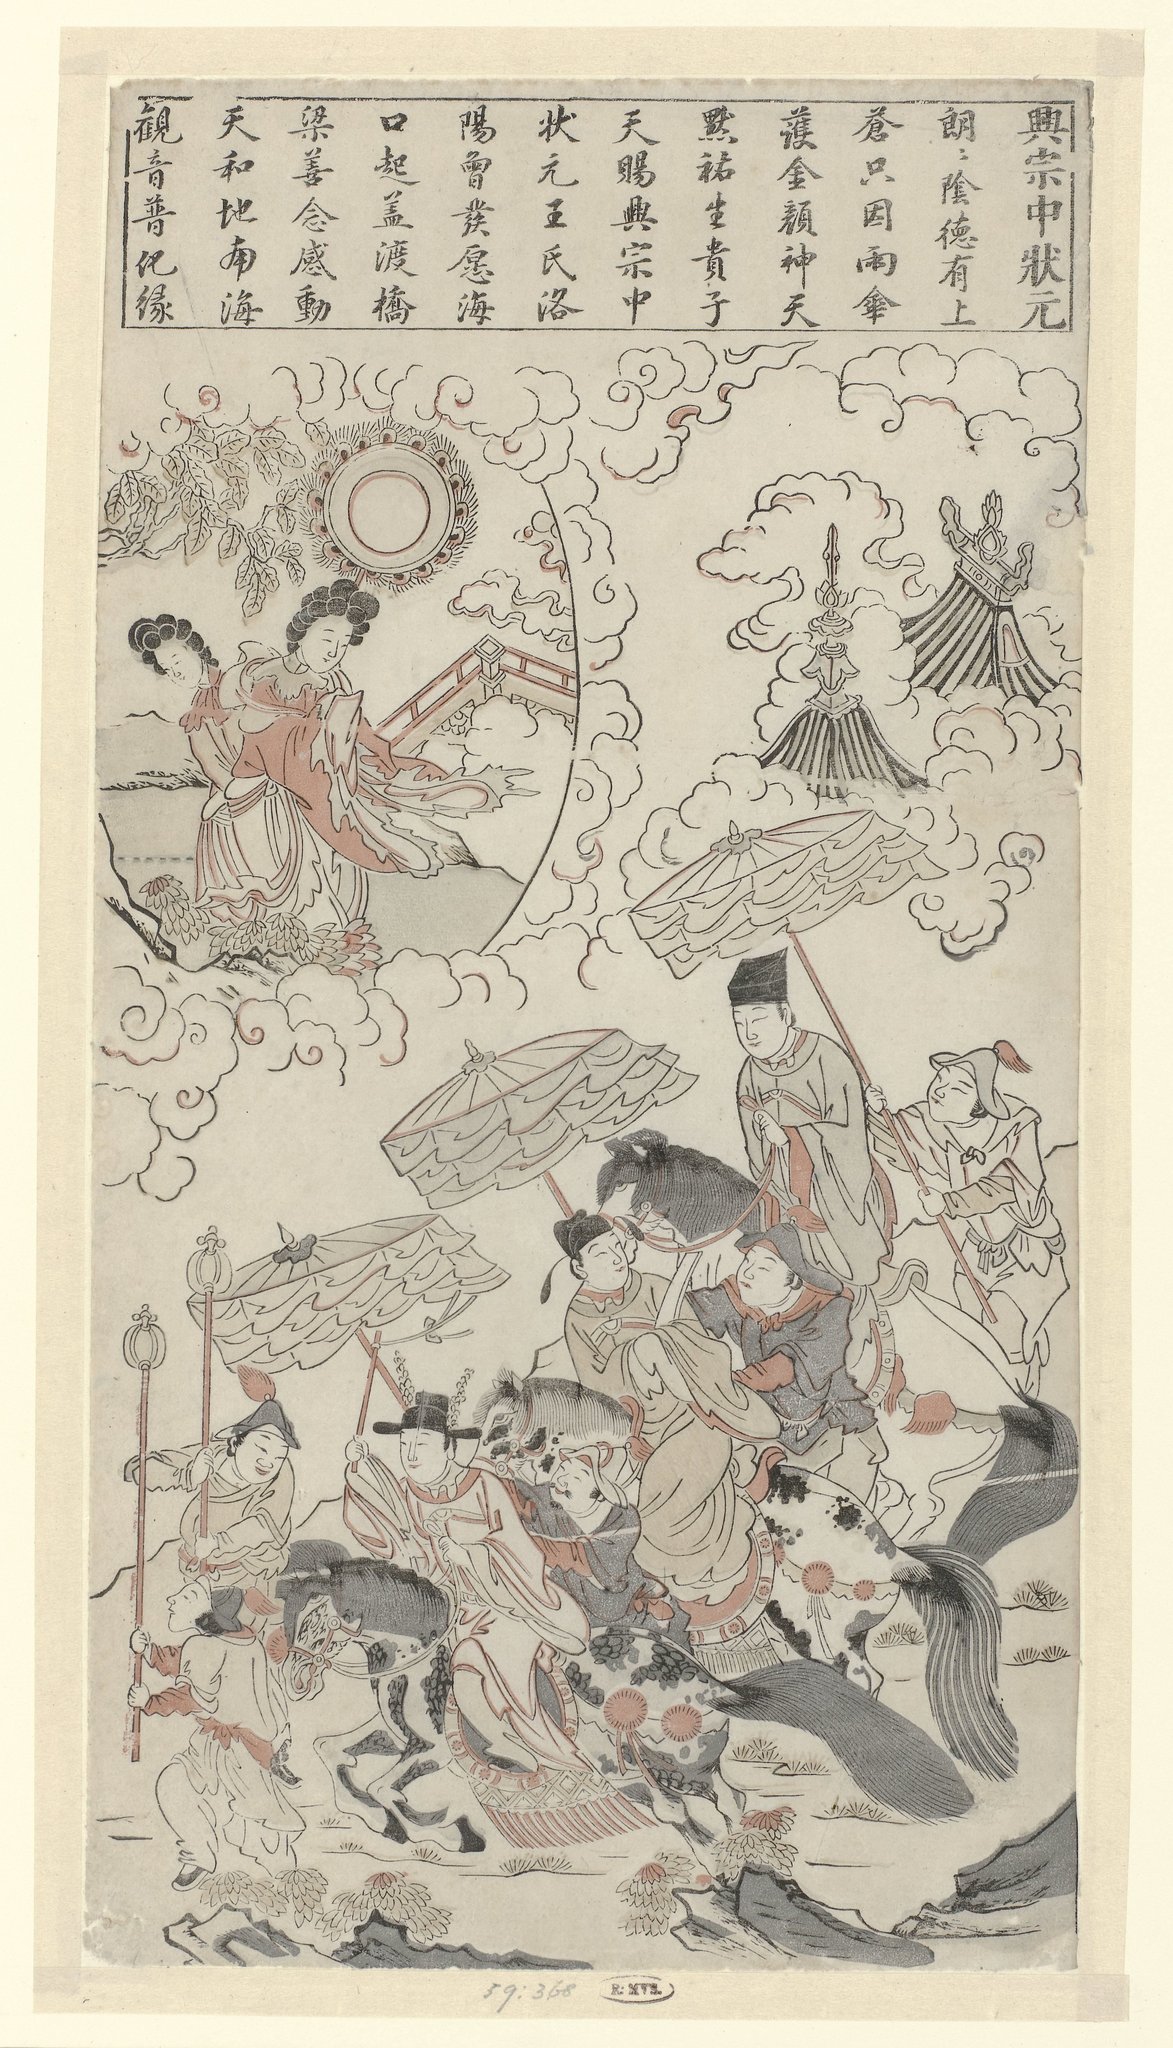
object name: print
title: Xingzhong Passes the Highest Imperial Examination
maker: Anonymous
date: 1600-1650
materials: paper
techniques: woodcut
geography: china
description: This print depicts one of the miracles that Guanyin performed. Thanks to a good deed by his mother, Xingzhong was blessed by Guanyin: he passed the imperial examination and returned home with this honour. Guanyin appears at the upper left, like a goddess, in the clouds. Xingzhong is the front horseman.